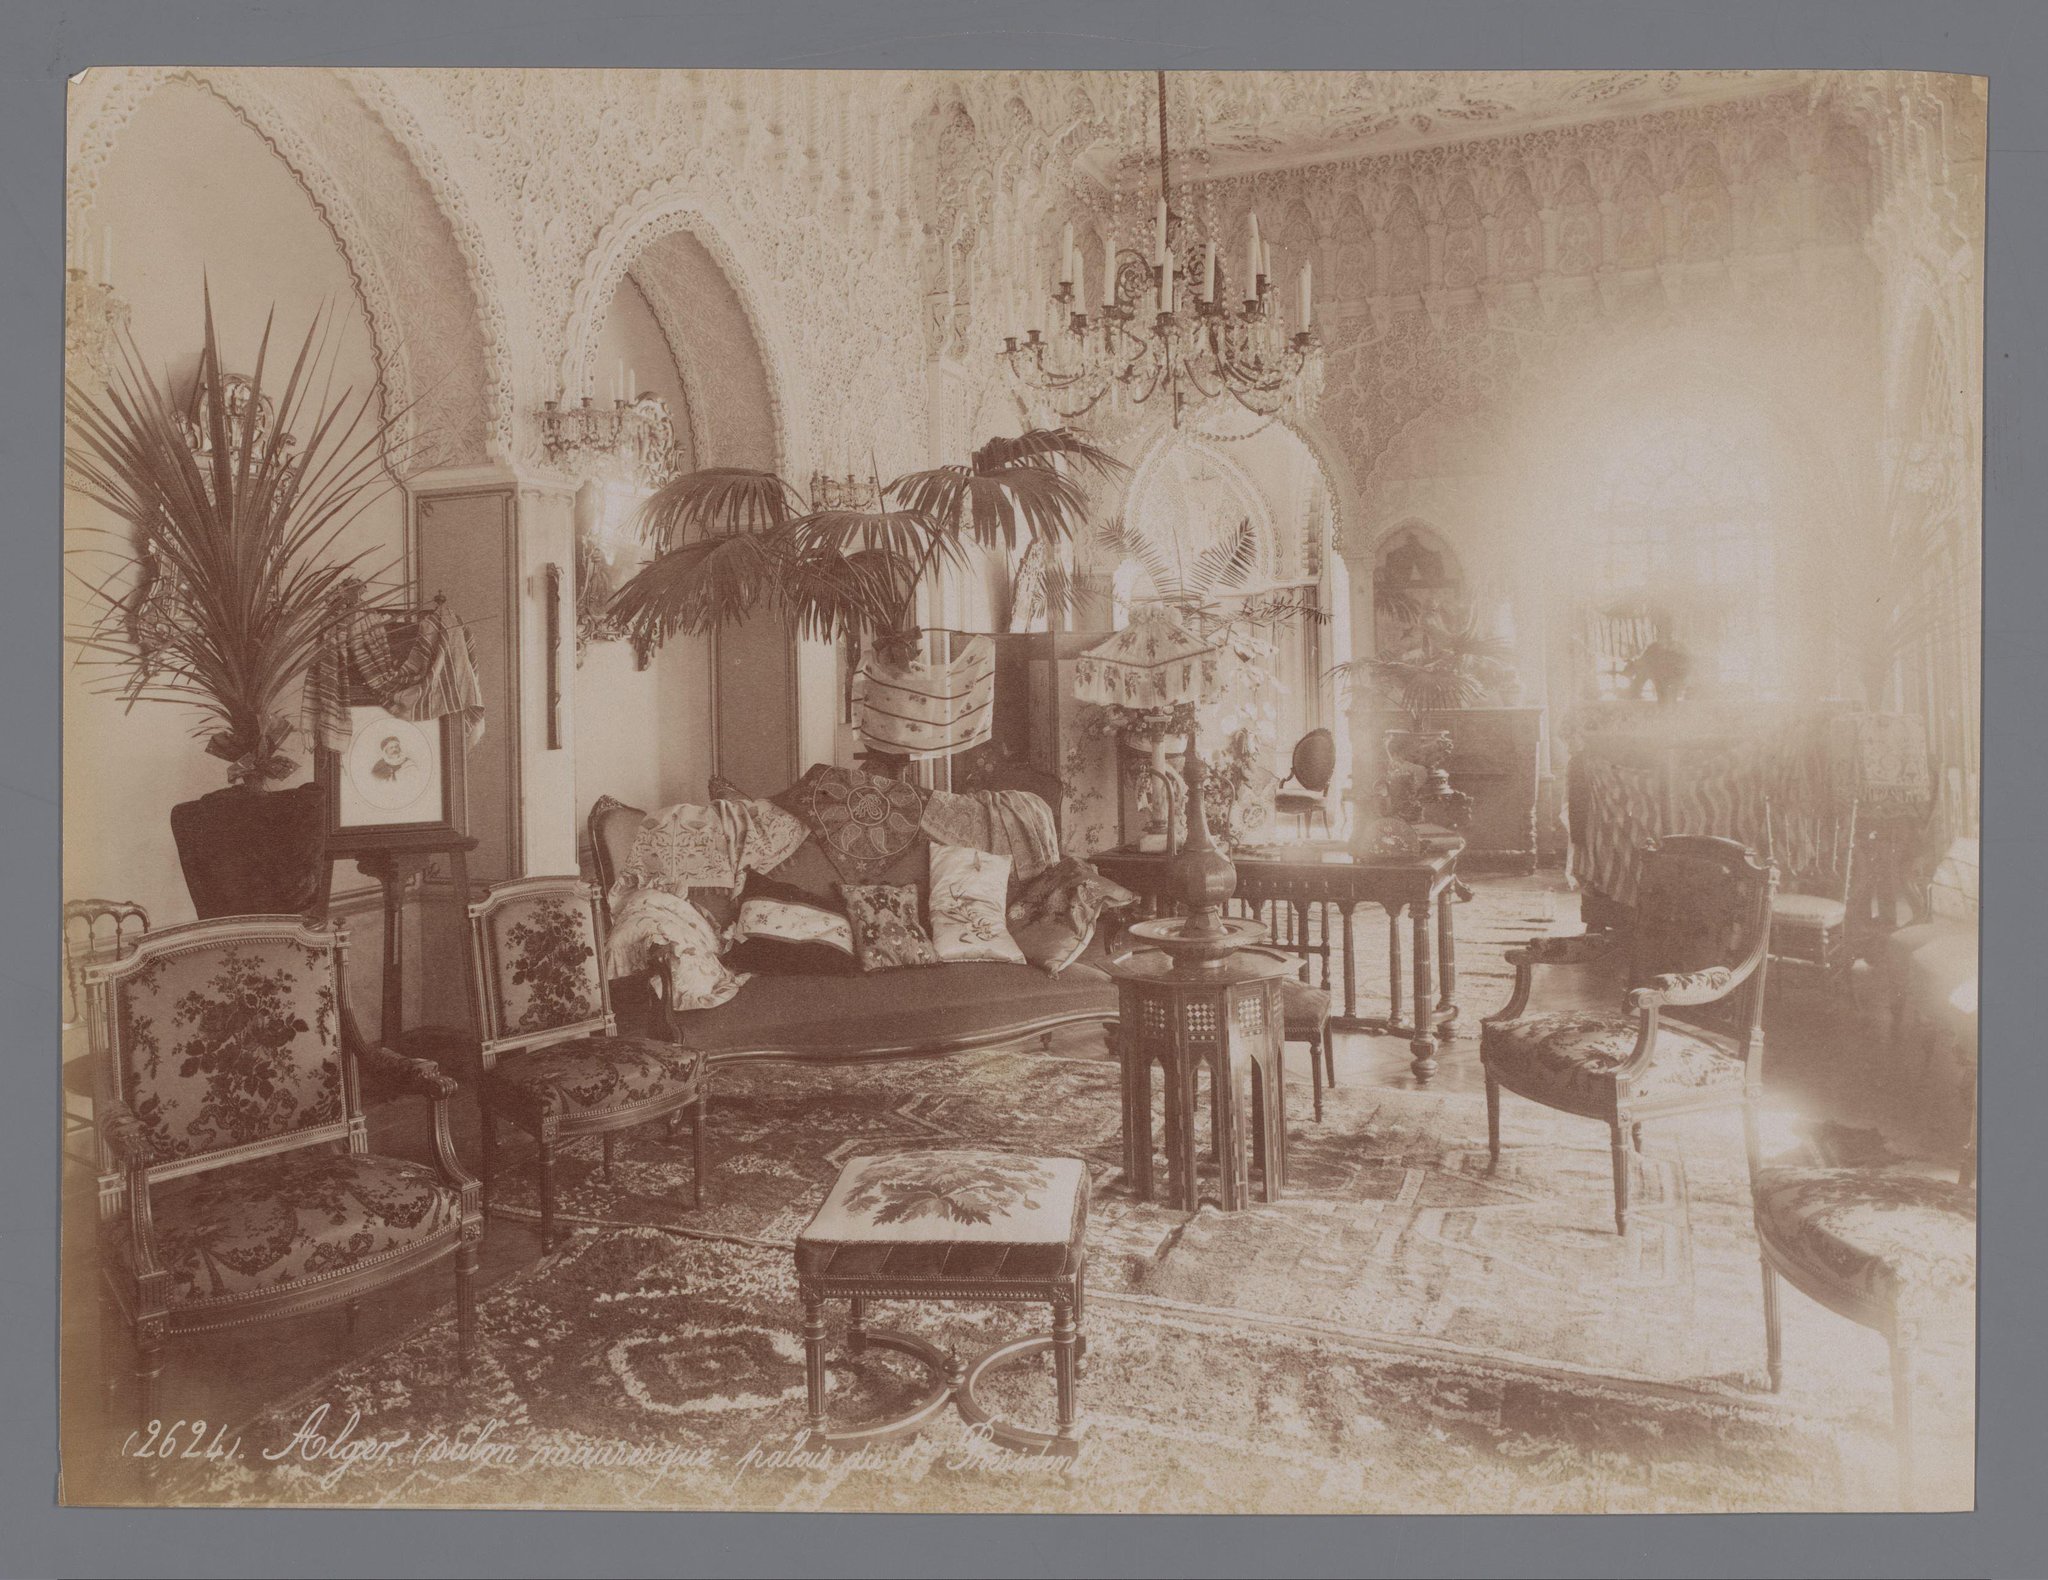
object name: photograph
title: Alger (salon mauresque, palais du 1e President)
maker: Anonymous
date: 1860-1900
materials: paper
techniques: albumen print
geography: algiers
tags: palace - aa - civic architecture: inside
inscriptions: number: ‘(2624).’